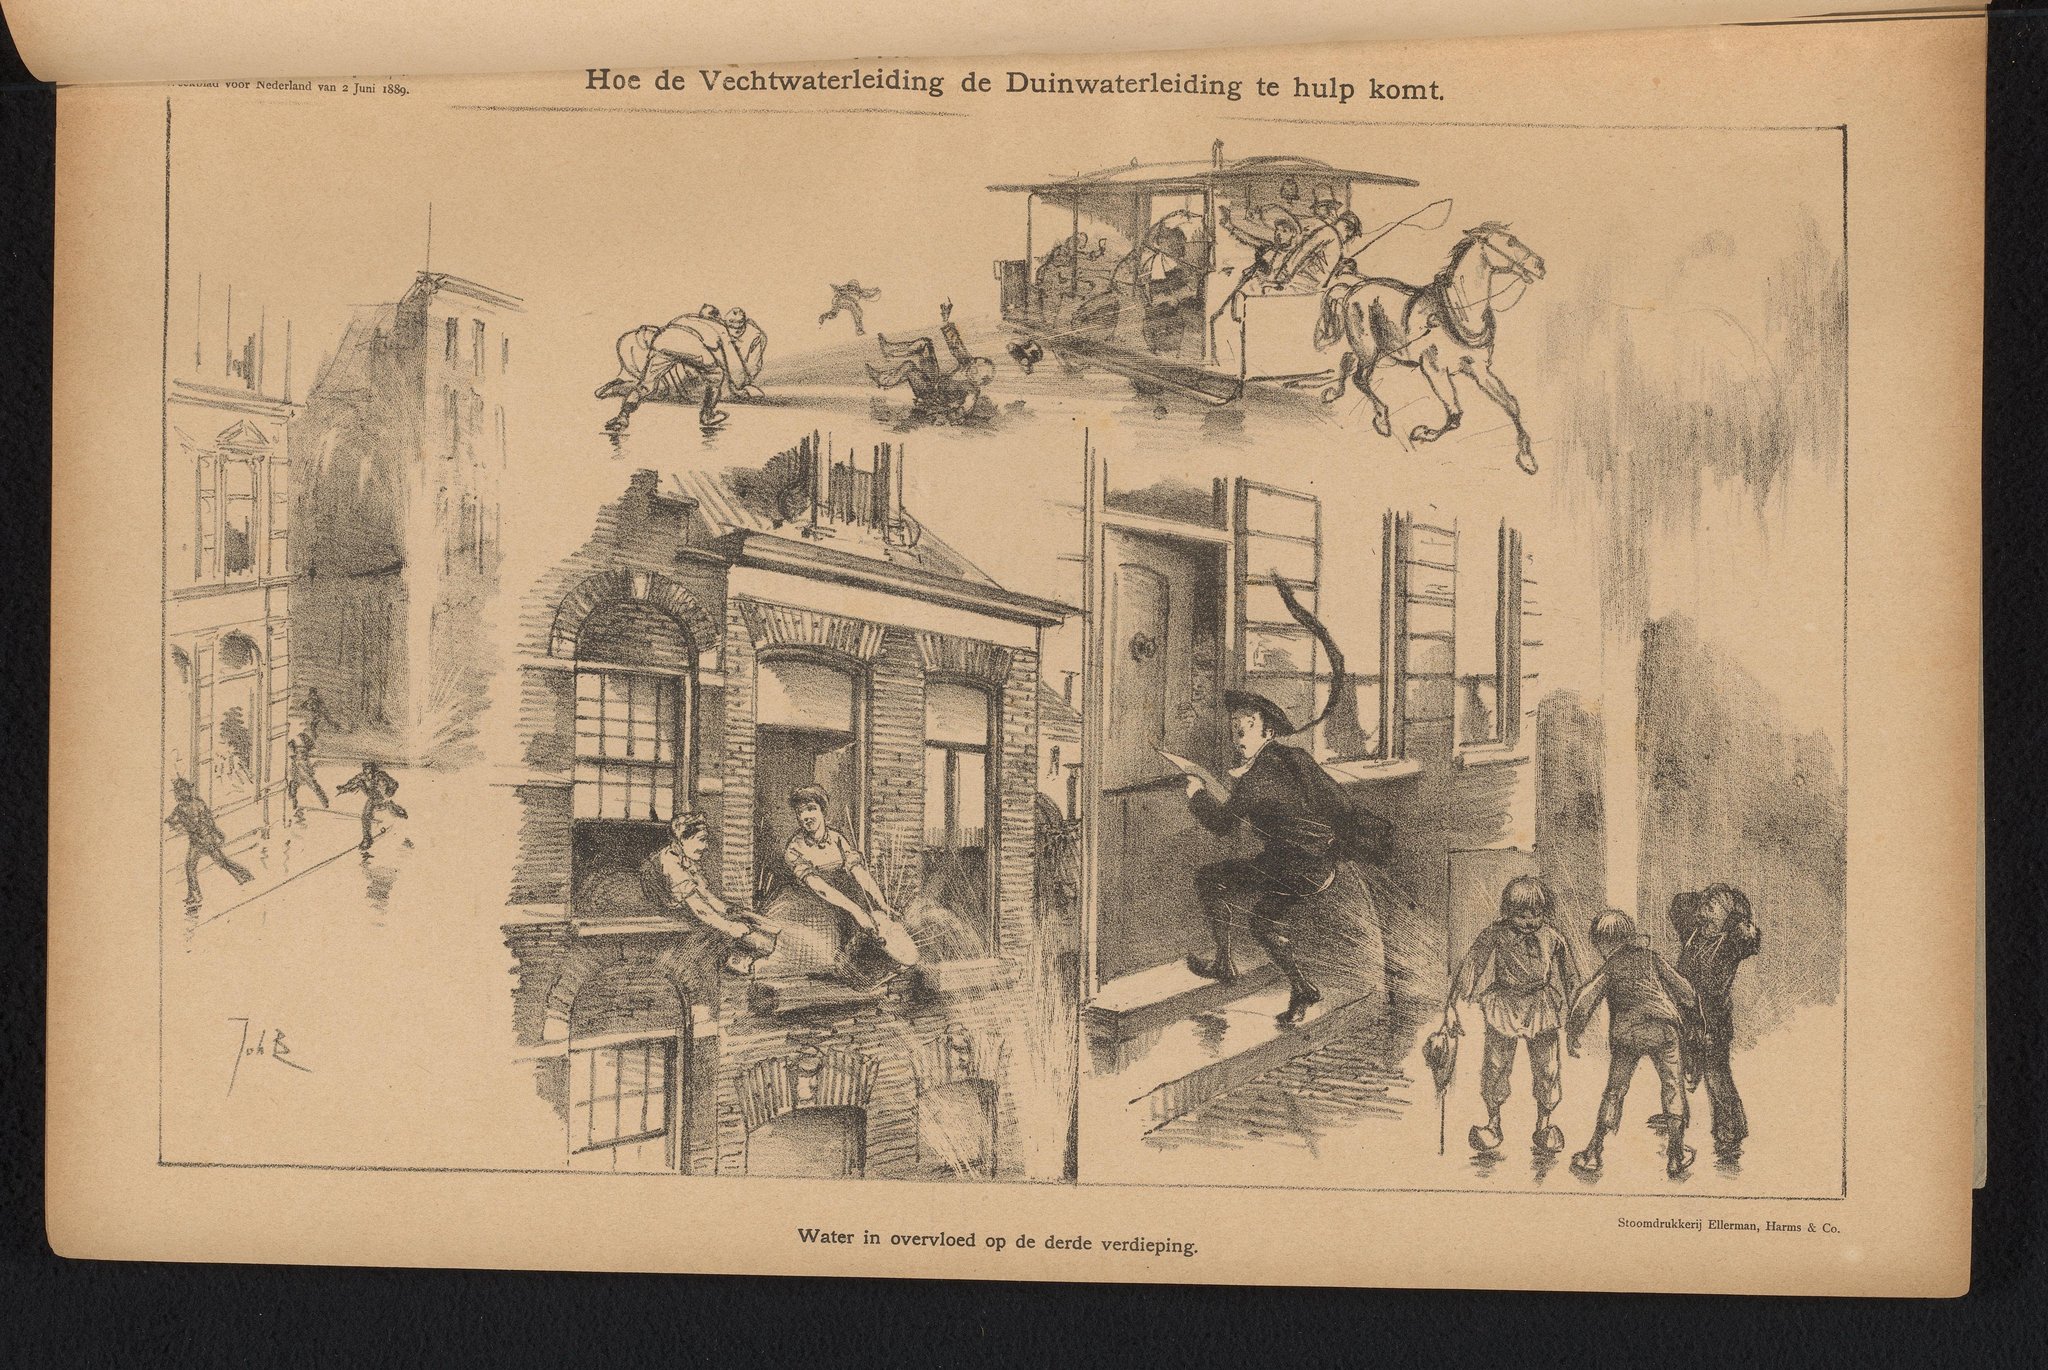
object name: cartoon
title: Hoe de Vechtwaterleiding de Duinwaterleiding te hulp komt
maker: johan braakensiek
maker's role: draughtsman, print maker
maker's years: 1858-1940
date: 1889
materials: paper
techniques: lithograph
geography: netherlands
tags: water-supply (~ public services), (playing with) toys ~ water, accident with diligence, omnibus, horse-tram, political caricatures and satires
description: Blad met verschillende humoristische illustraties van de gevolgen van het breken van de waterleiding.